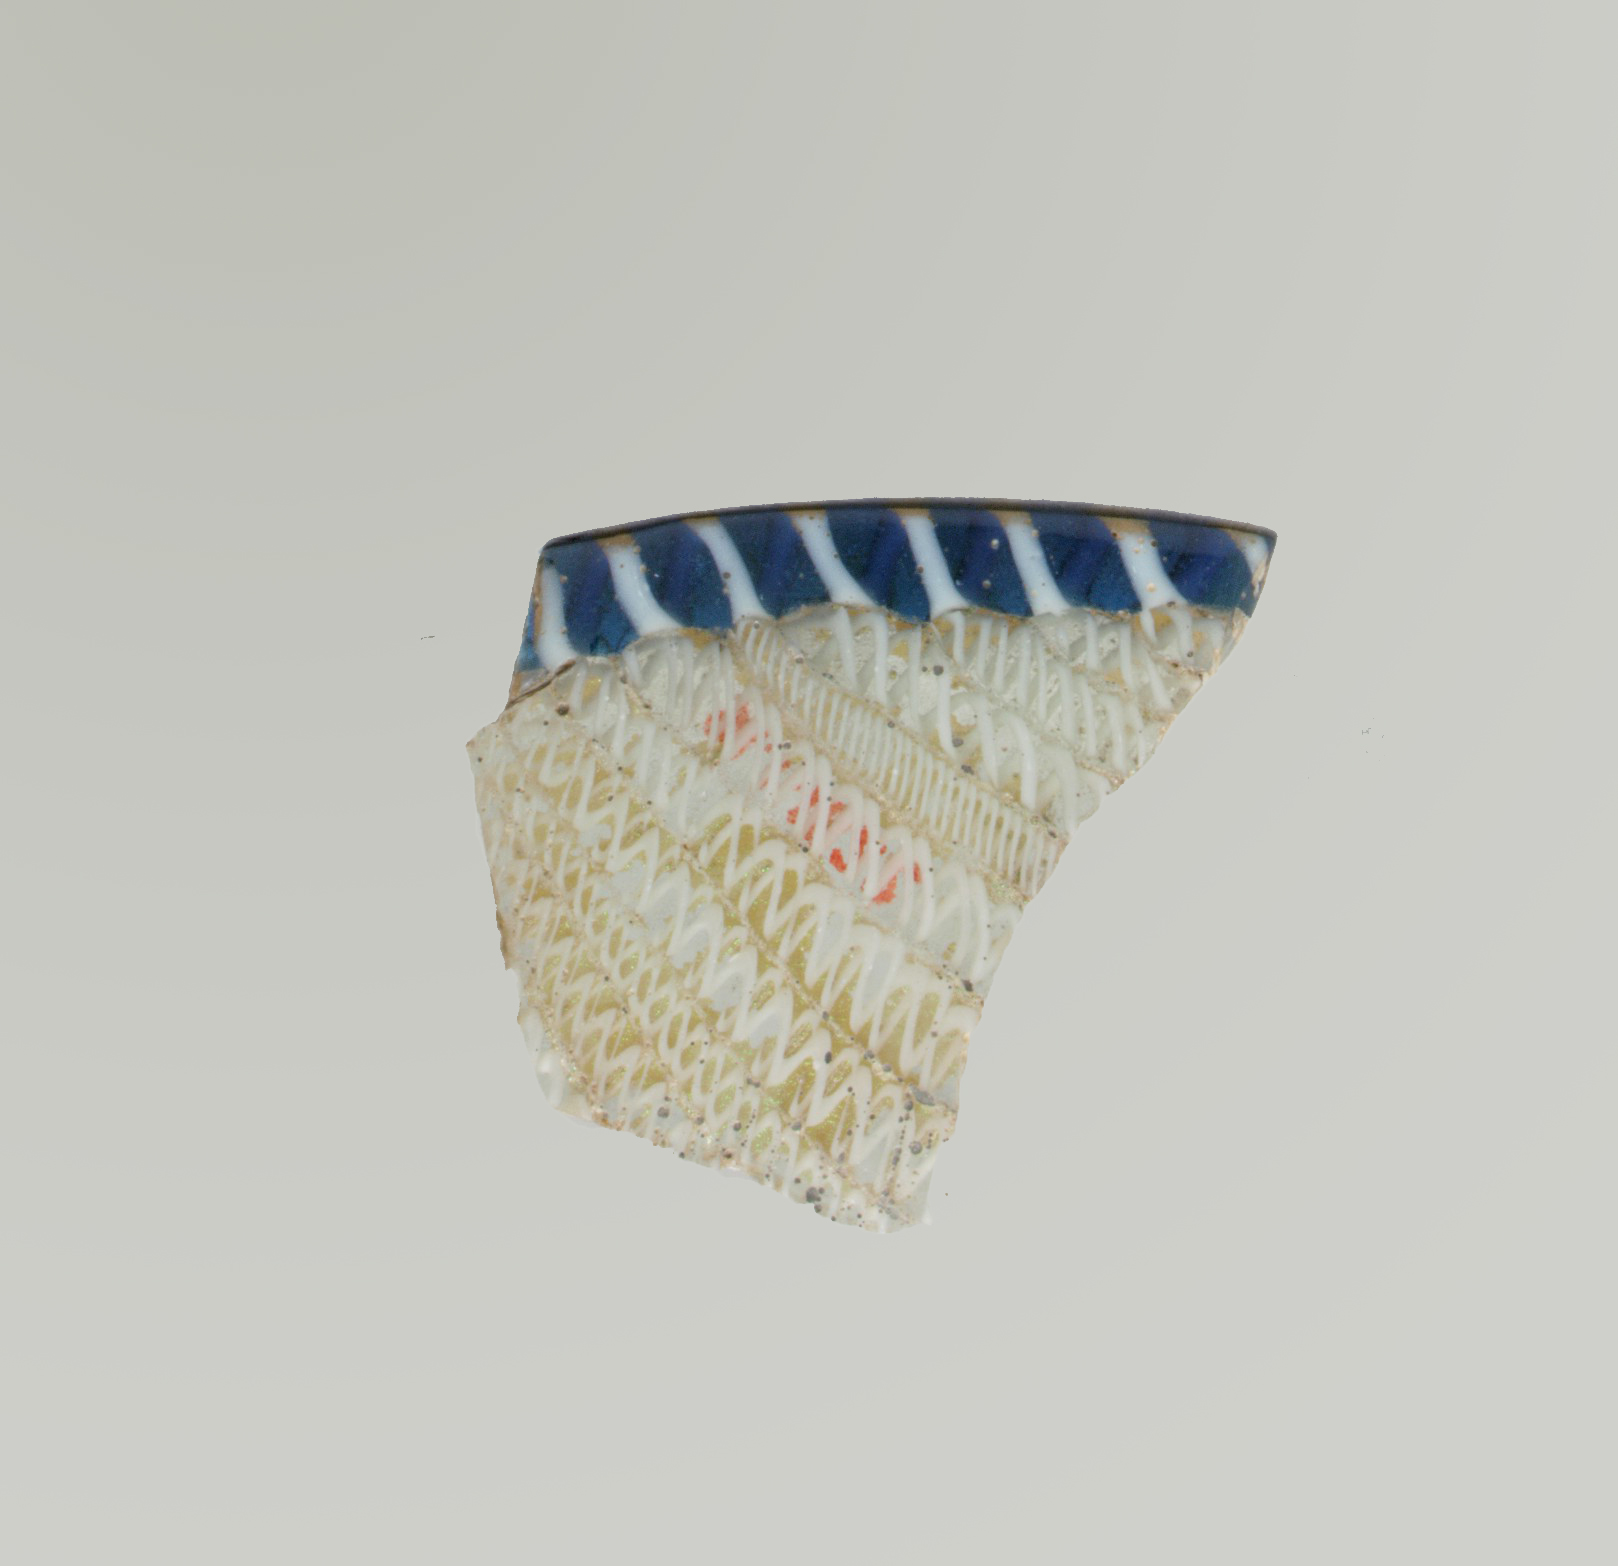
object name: fragment, network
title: Glass network mosaic bowl fragment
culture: roman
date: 34 BCE-33 CE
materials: glass